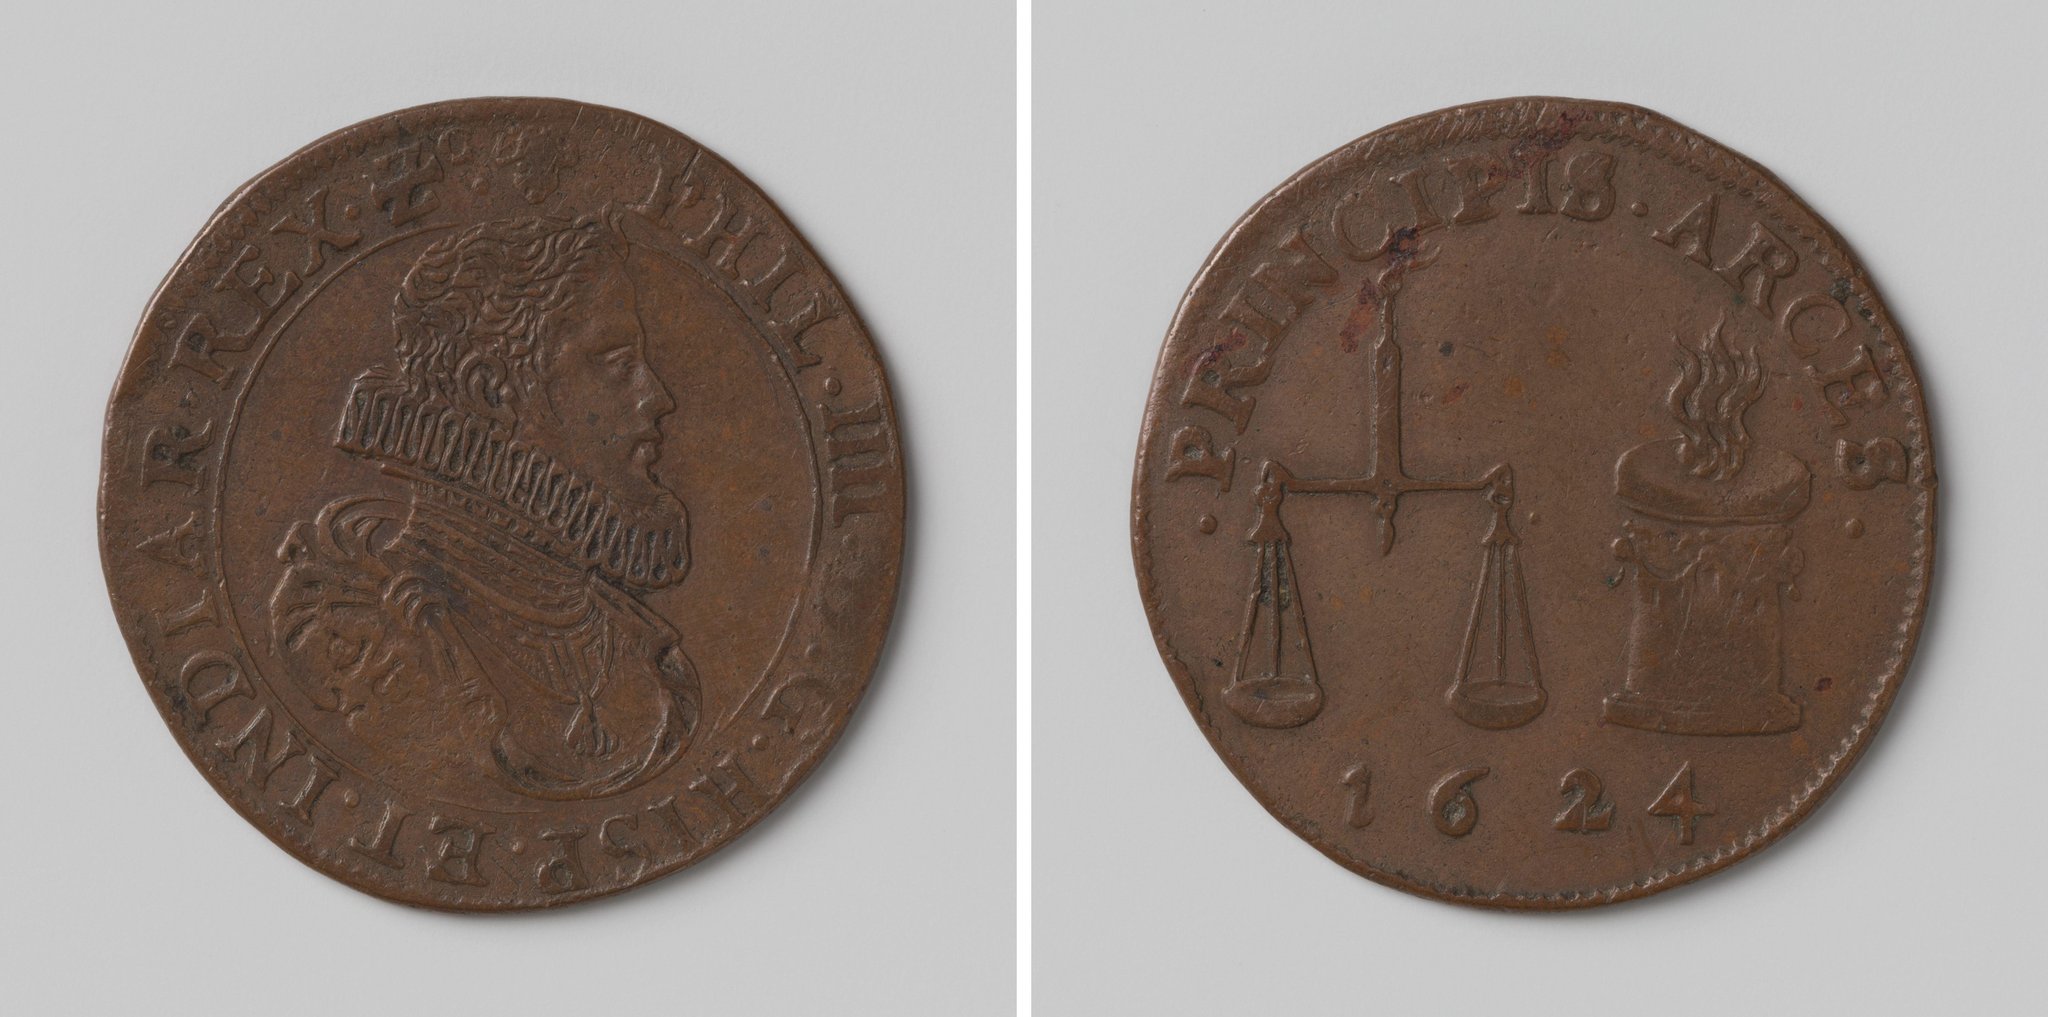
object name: jeton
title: Filips IV, koning van Spanje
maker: Anonymous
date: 1624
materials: copper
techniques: striking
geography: brussels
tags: filips iv (koning van spanje)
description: Koperen penning. Voorzijde: borststuk man binnen omschrift. Keerzijde: weegschaal in evenwicht, naast een brandend altaar binnen omschrift